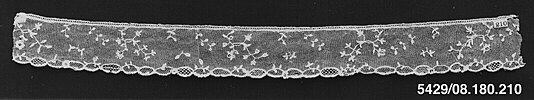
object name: collar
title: Collar (?)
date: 1801-1900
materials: lace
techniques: lace